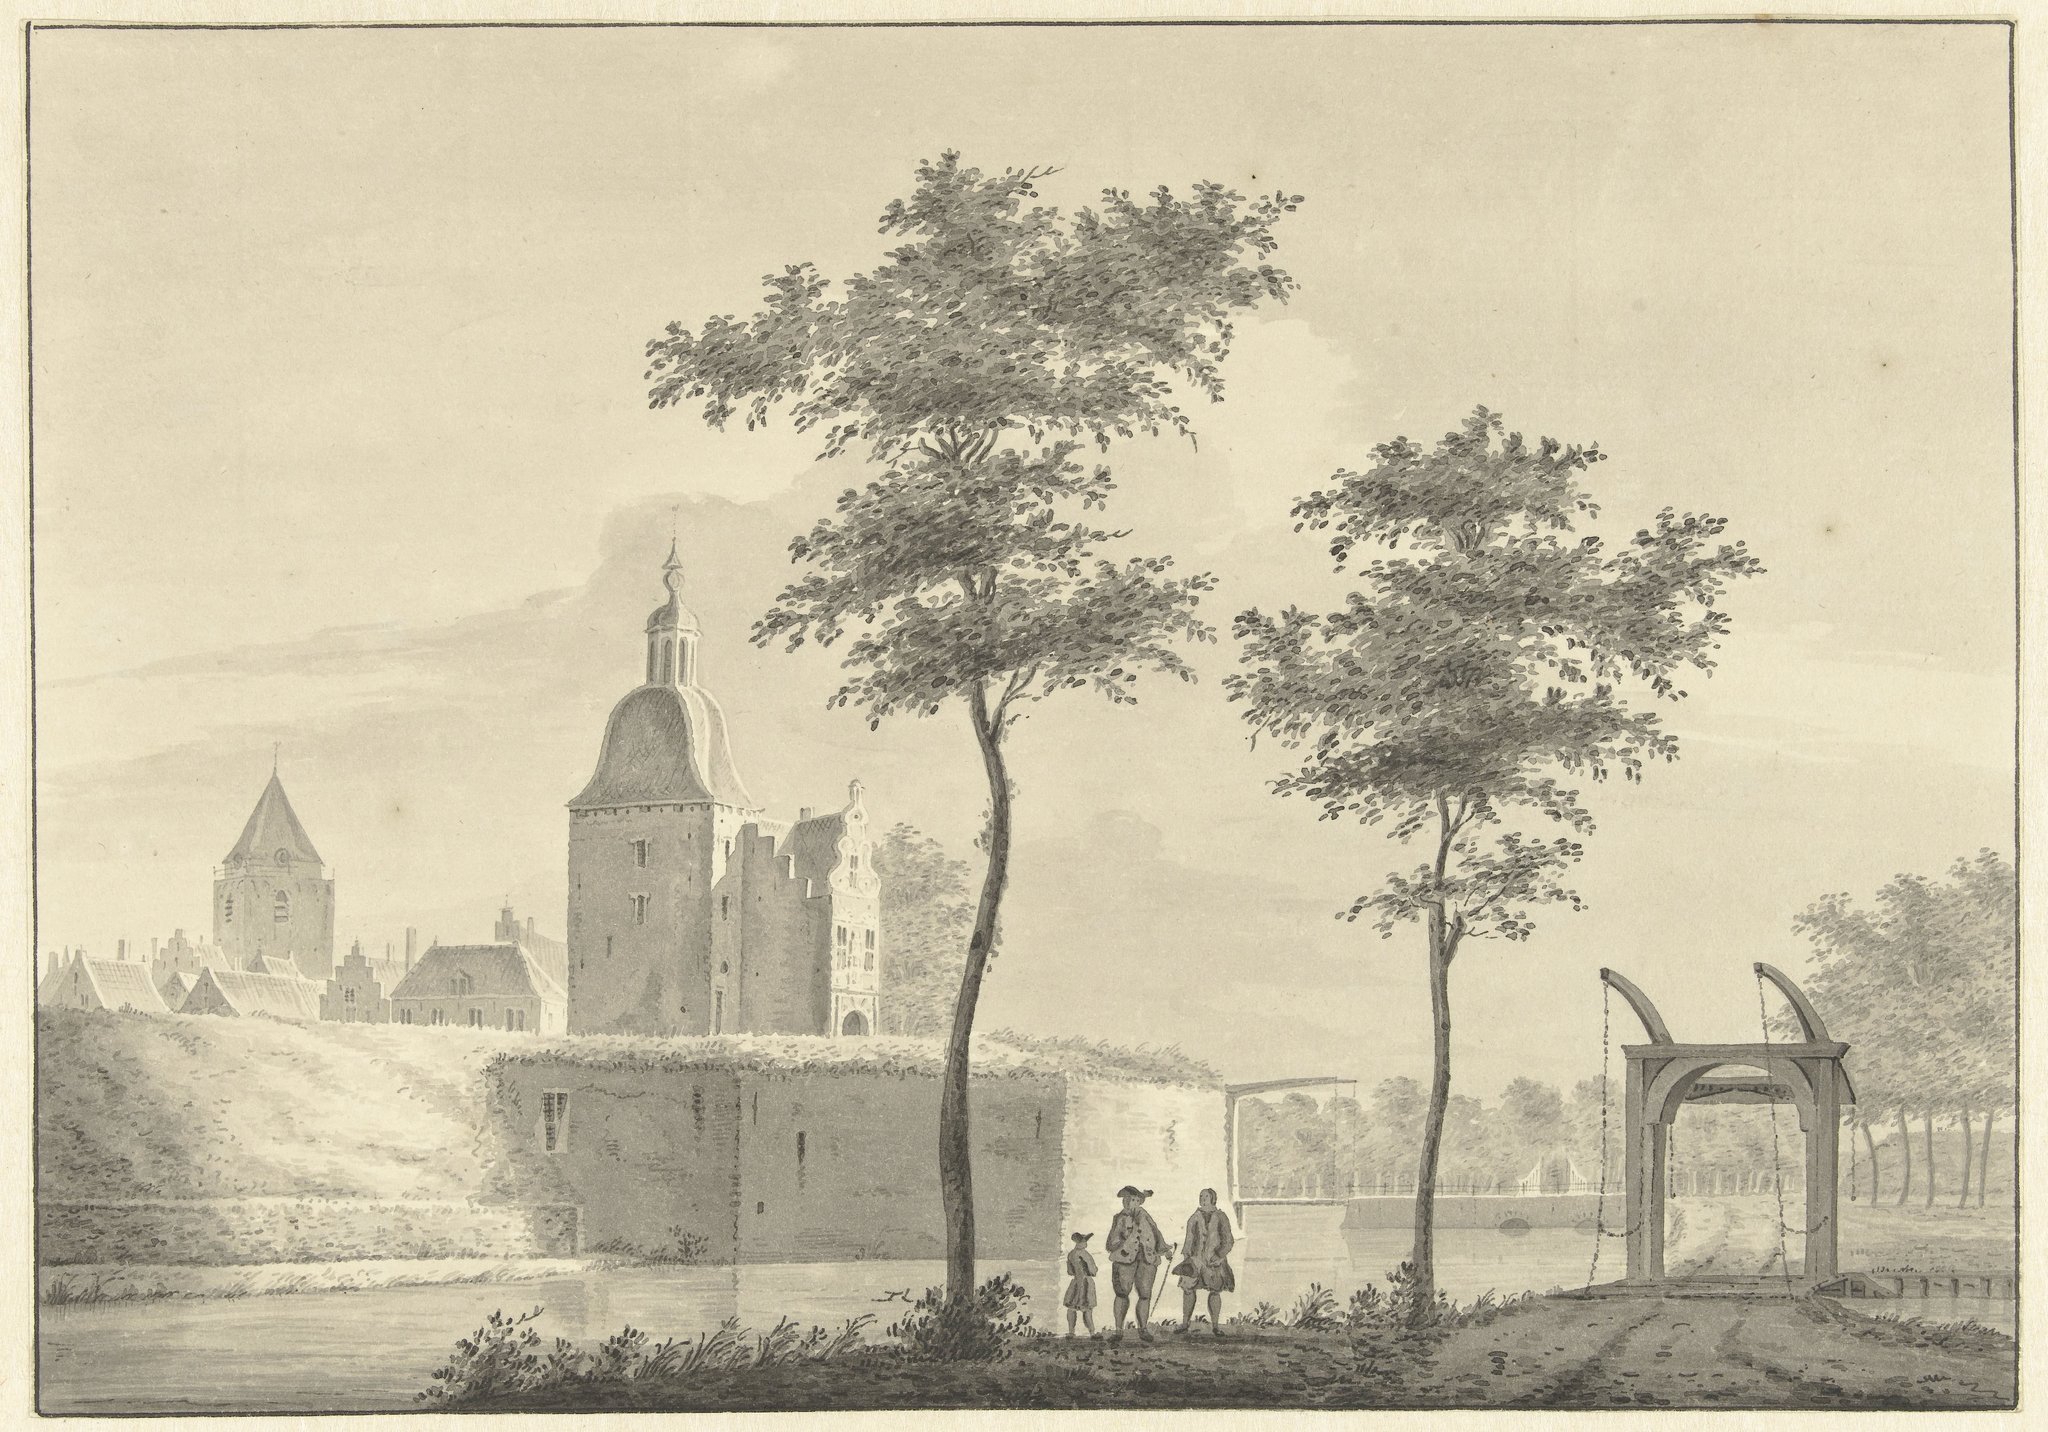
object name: drawing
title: De Leidse Poort te Woerden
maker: theodorus cornelis schutter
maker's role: draughtsman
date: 1750-1776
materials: paper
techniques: brush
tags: city-gate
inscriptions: inscription: ‘De Leydsche Poort tot Woerden / T.C Schutter f’